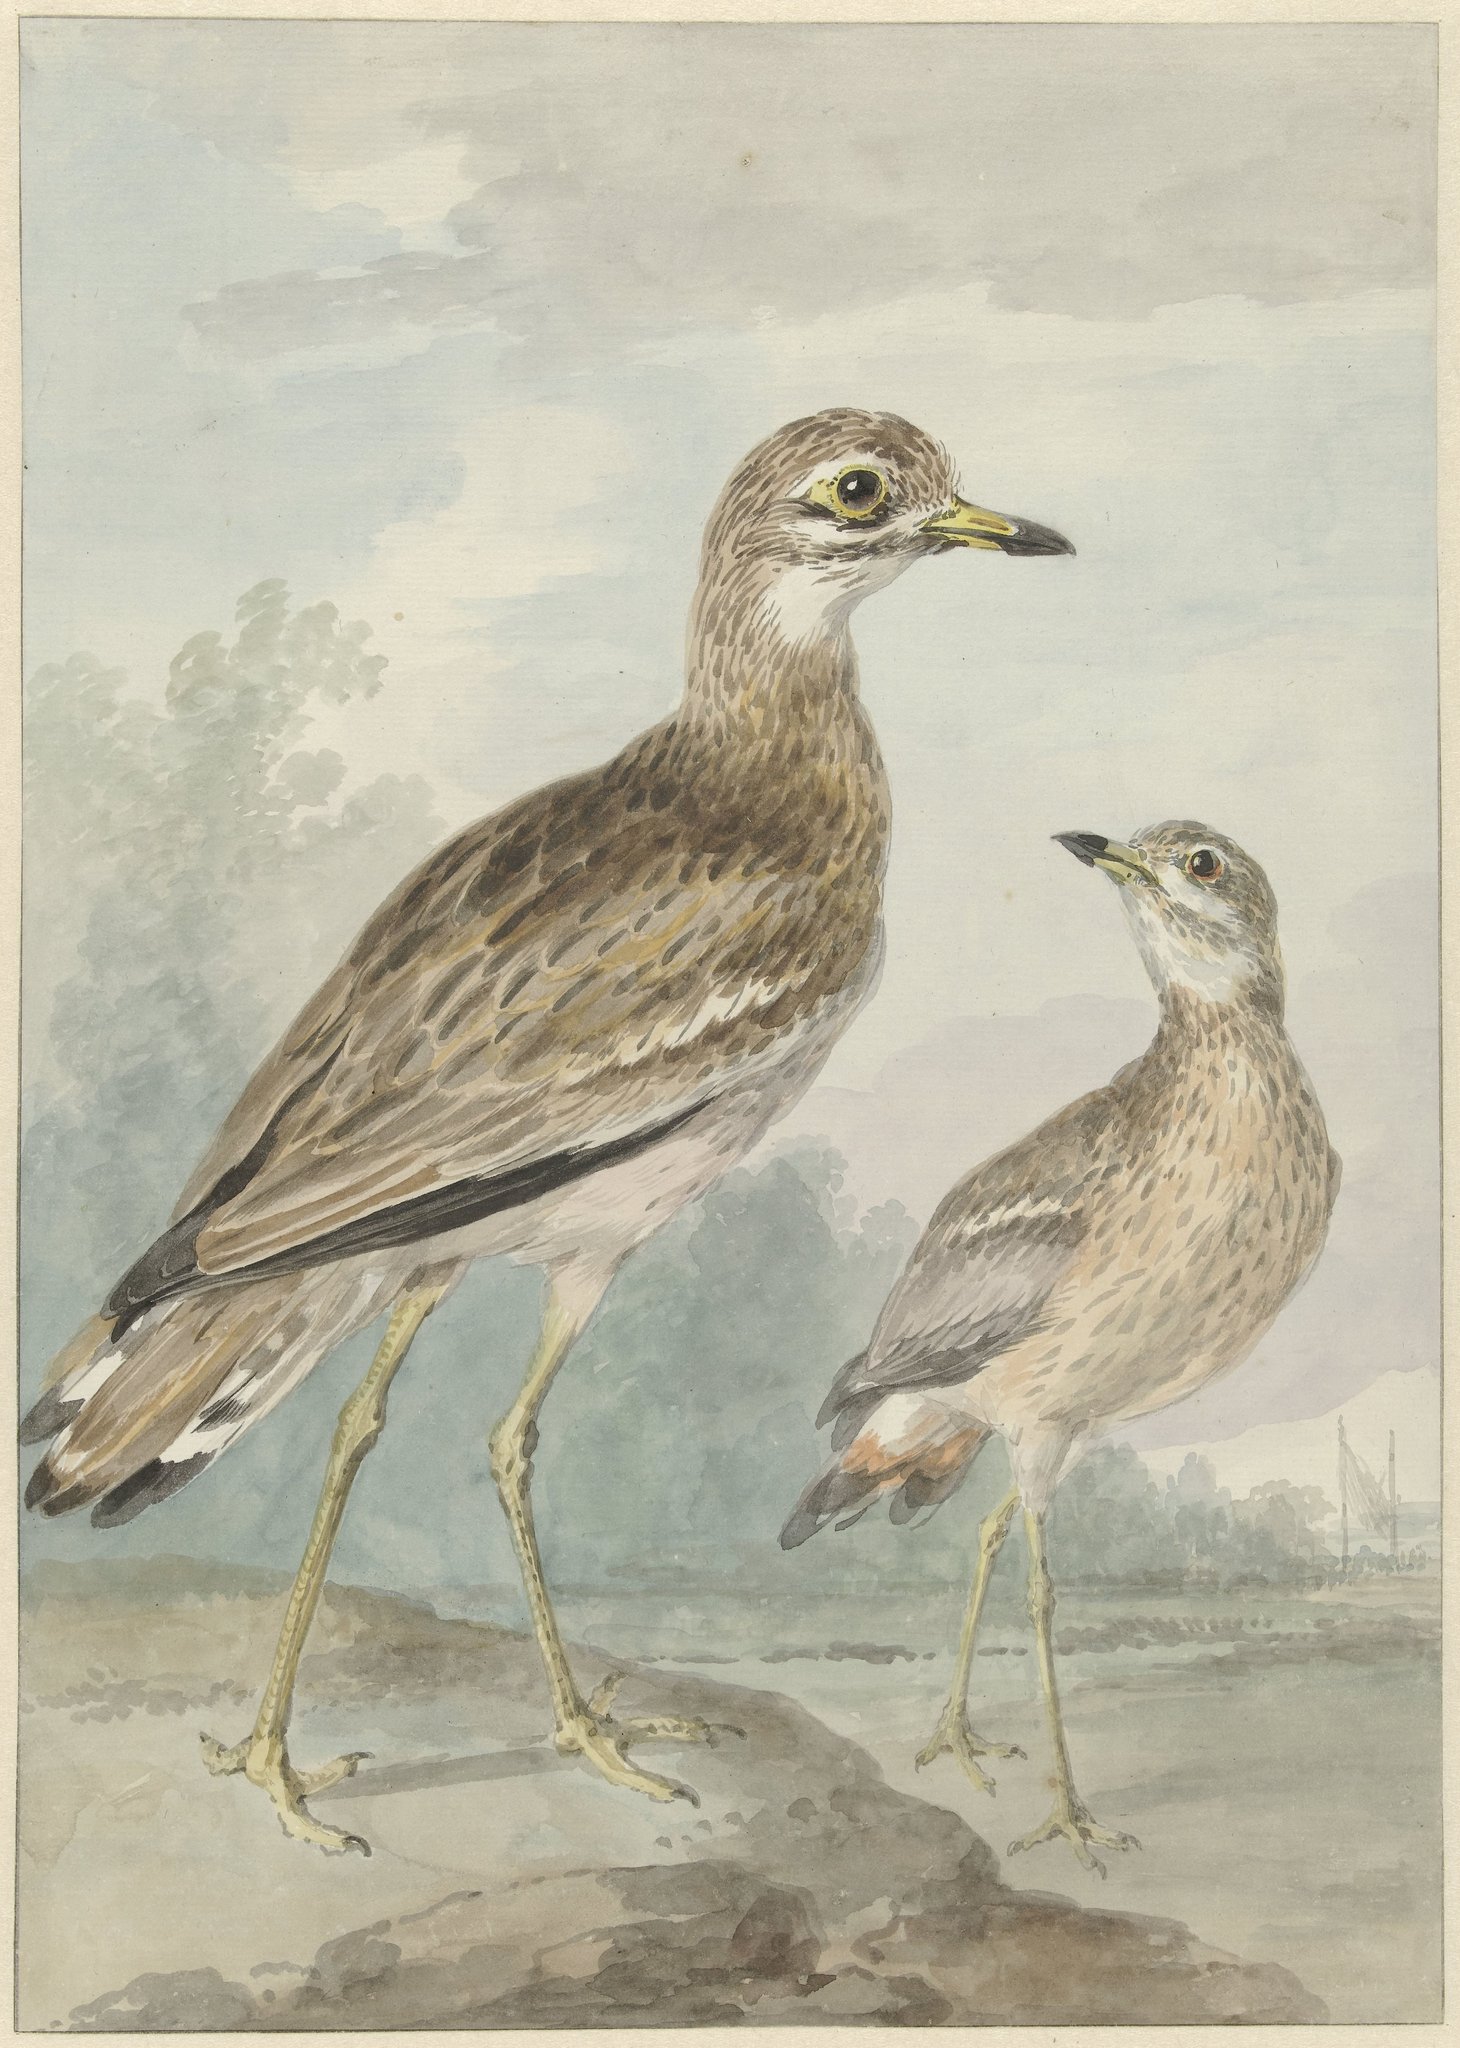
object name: drawing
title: Twee grielen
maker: aert schouman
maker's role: draughtsman, painter, print maker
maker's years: 1710-1792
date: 1777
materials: paper, watercolor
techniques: brush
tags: shore-birds and wading-birds: stone curlew, shore-birds and wading-birds: plover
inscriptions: inscription: ‘Dese vogel getekent na een die gevangen is in het flouwnet op de buyteplaats Schuddegeest / toe behorende de WelE heer K. ten hoven. en komt mijn voor de dubbele pluivier te zijn / levensgroot, wel de helft, als de ordonare pleuvier A. S. 1777. en berust by de Ed. heer / [?] / No. 1544’